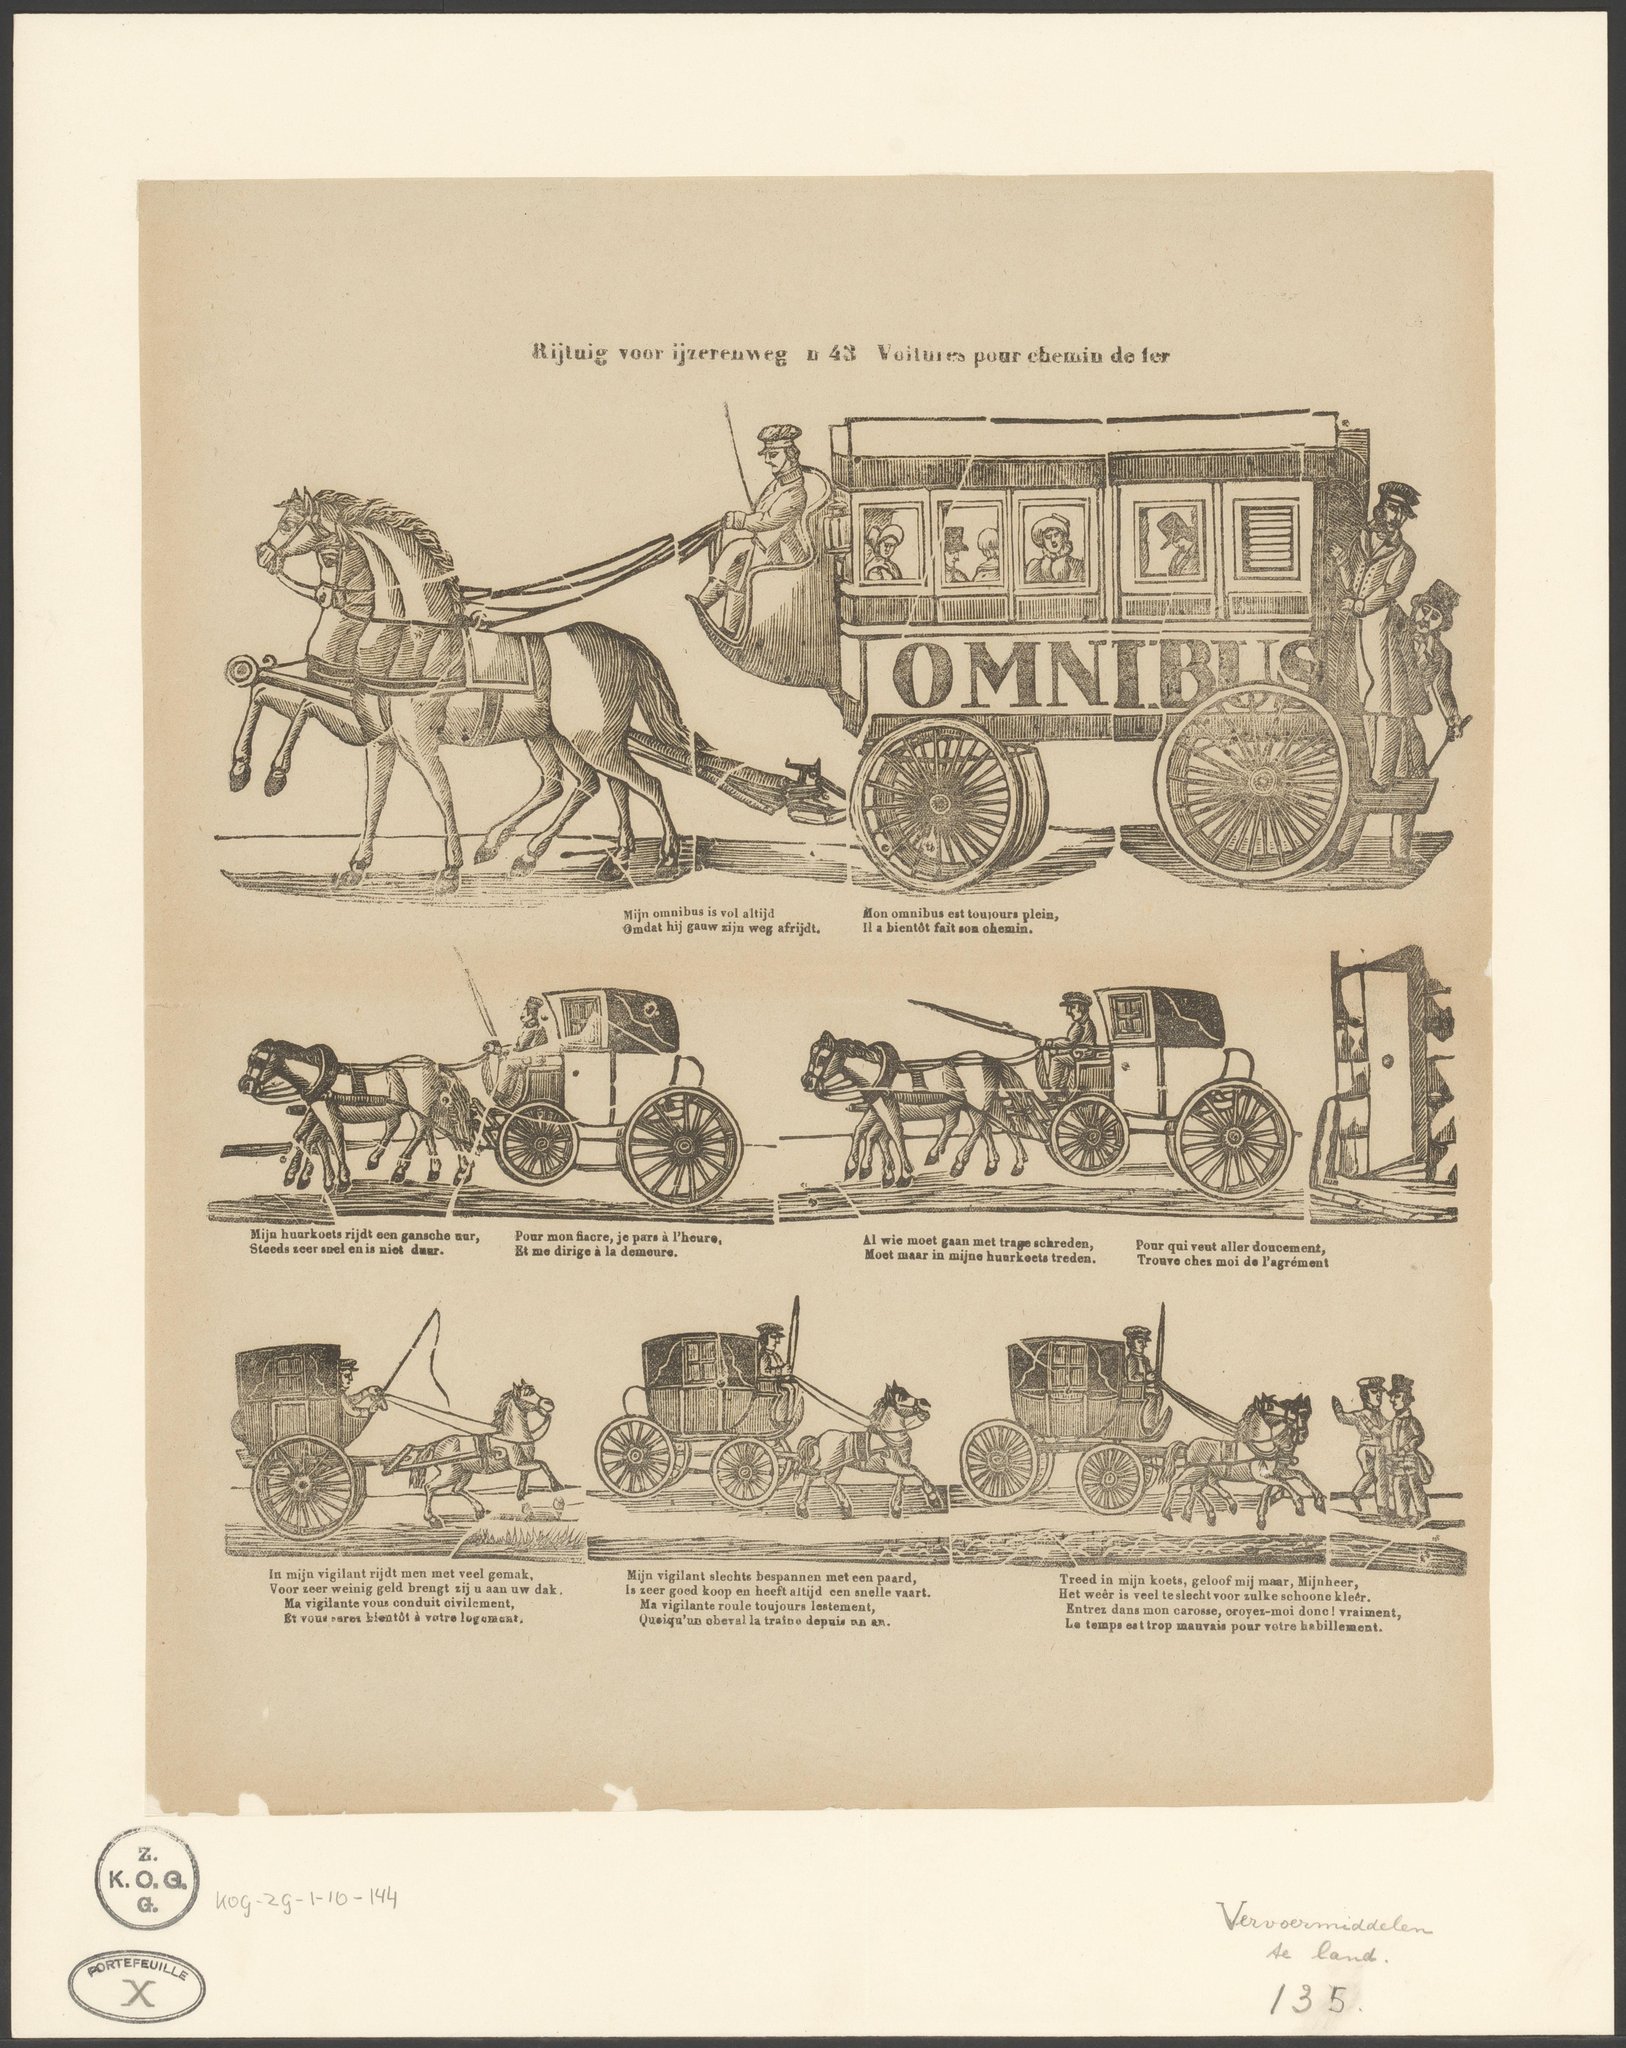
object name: print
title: Paardenbus en andere rijtuigen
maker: Anonymous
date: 1856-1900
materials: paper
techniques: letterpress printing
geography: turnhout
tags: diligence, omnibus, horse-tram, four-wheeled, animal-drawn vehicle, e.g.: cab, carriage, coach, two-wheeled vehicle drawn by one animal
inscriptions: collector's mark: Lugt 1641, stamp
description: Acht door paarden getrokken vervoersmiddelen in drie rijen. Bovenaan de omnibus of paardenbus. Onder elke voorstelling een onderschrift in het Nederlands en in het Frans. Genummerd midden boven: n 43. Onderwerpsrubrieken binnen de Atlas Zeden en Gewoonten: Handel, nijverheid en verkeer, Vervoermiddelen te land en te water, vervoermiddelen te land, Spoorwegen.